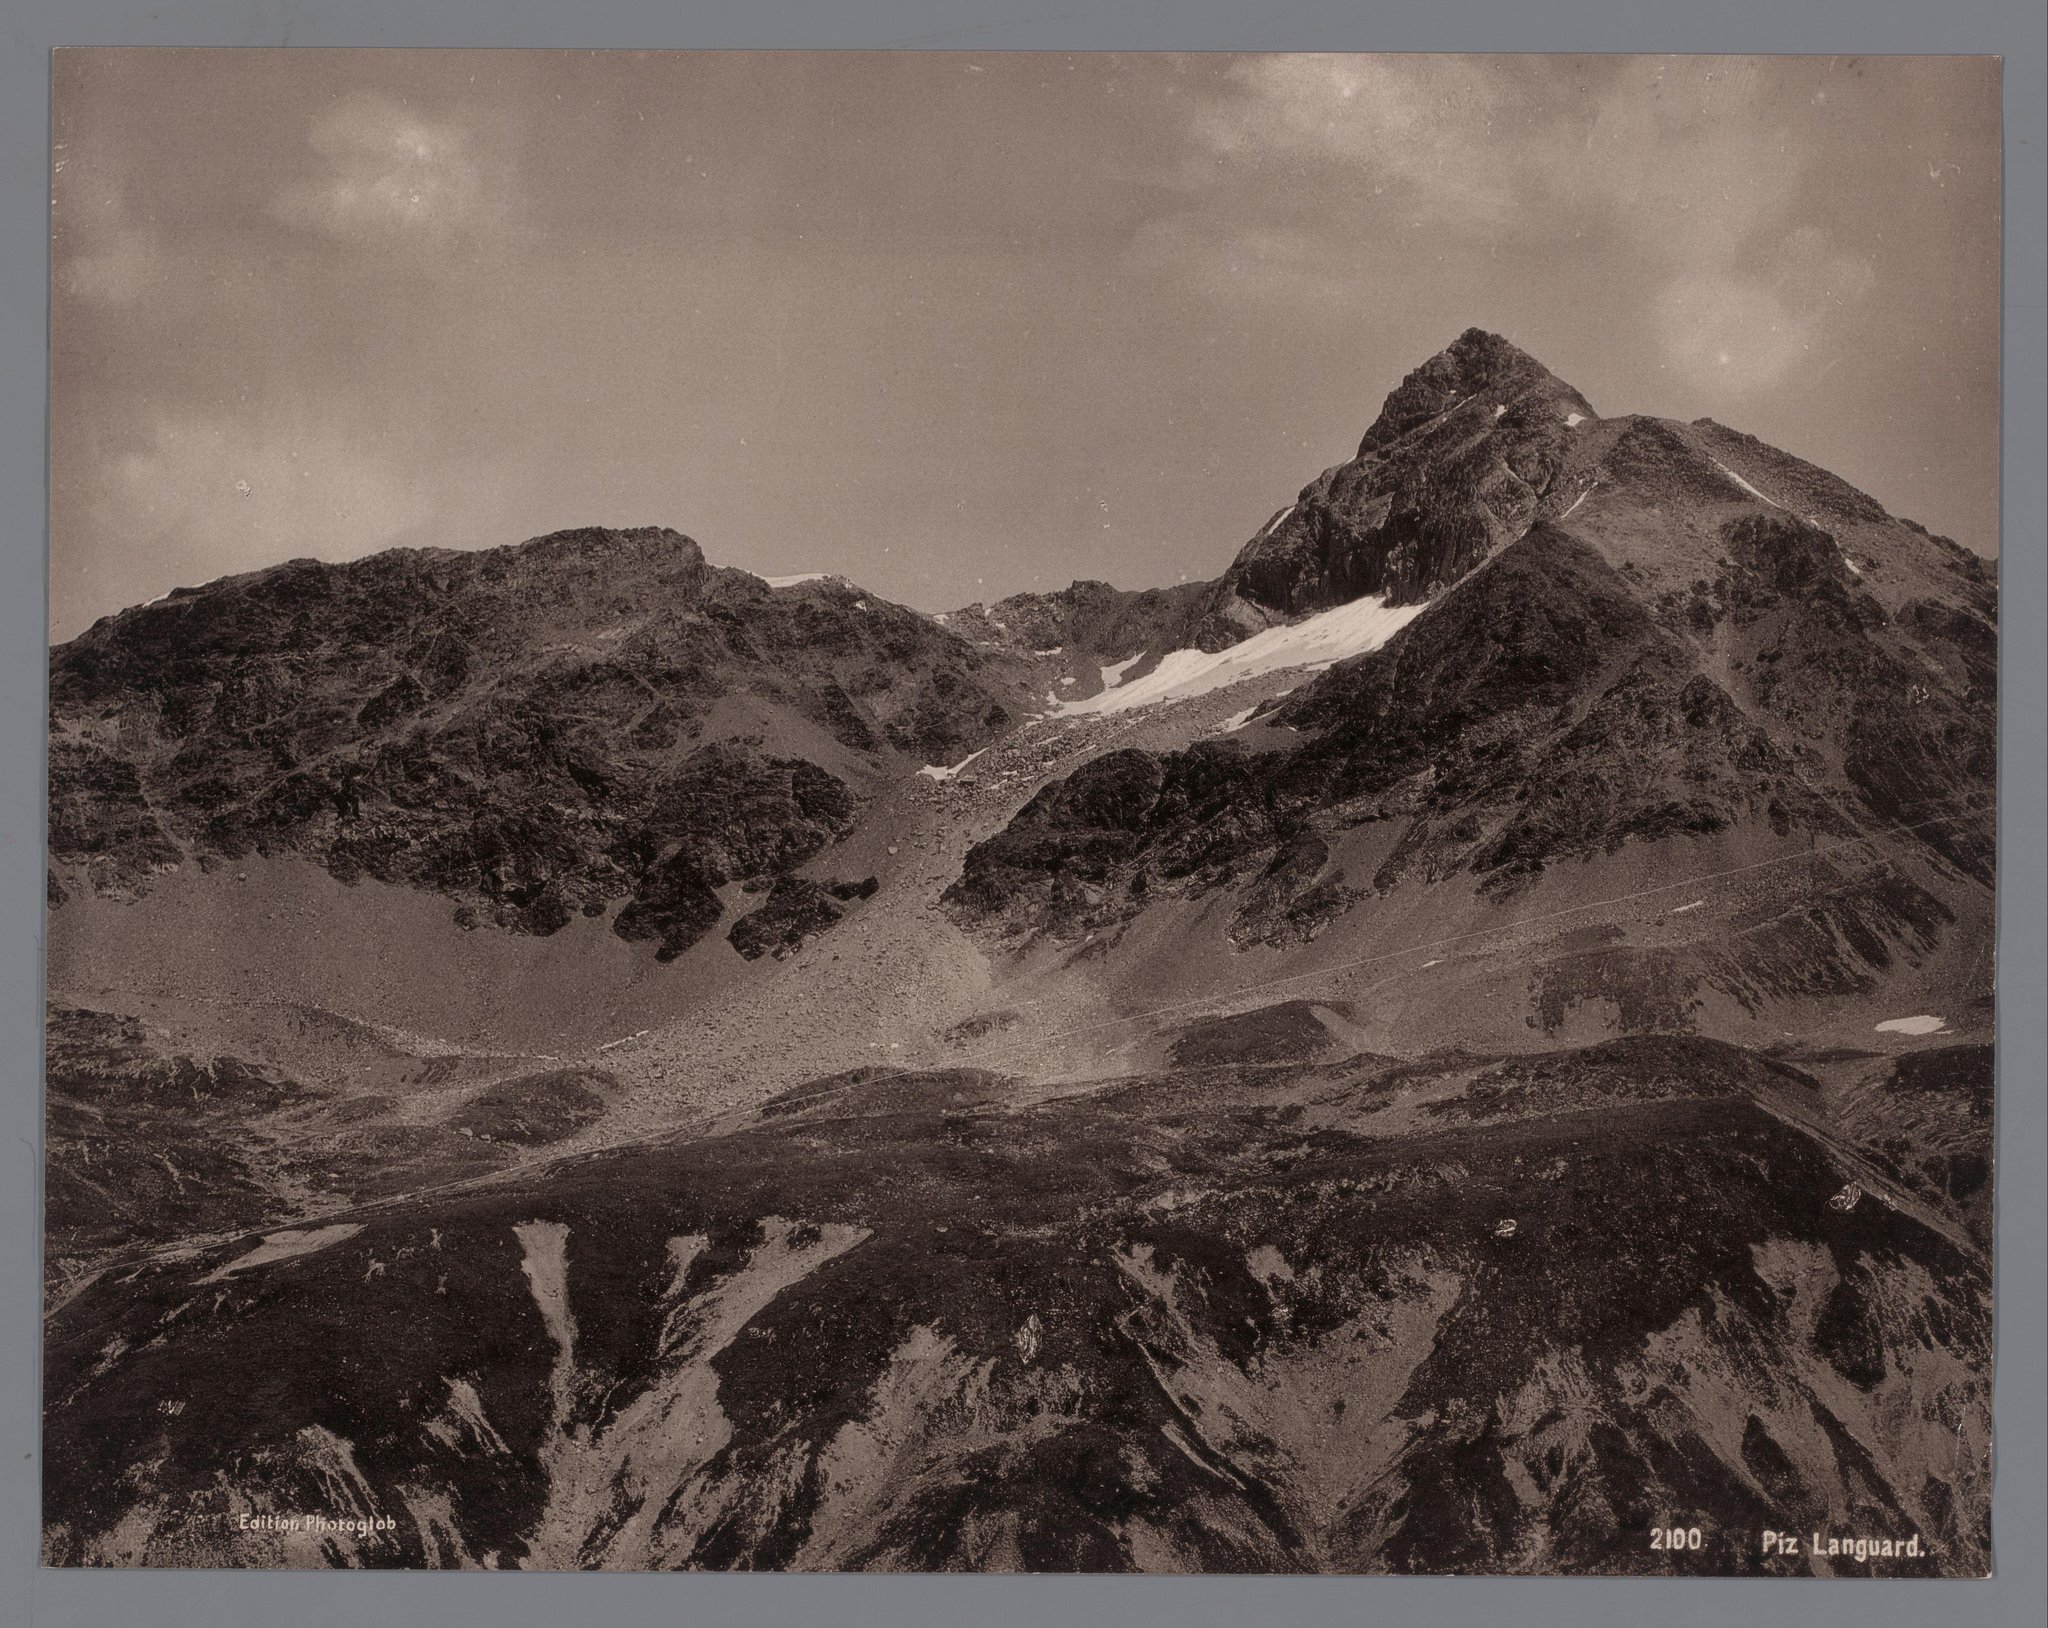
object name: photograph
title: "Piz Languard", Alpen, Zwitserland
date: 1890-1915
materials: paper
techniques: photograph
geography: switzerland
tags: switzerland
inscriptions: inscription: ‘F.’, inscription: ‘2100 Piz Languard.’, inscription: ‘Edition Photoglob’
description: Gezicht op Piz Languard (3260m), een gletsjer waar zich een bekend uitzichtpunt bevindt op onder andere de gletsjers Bernina, Ortler en Silvretta.